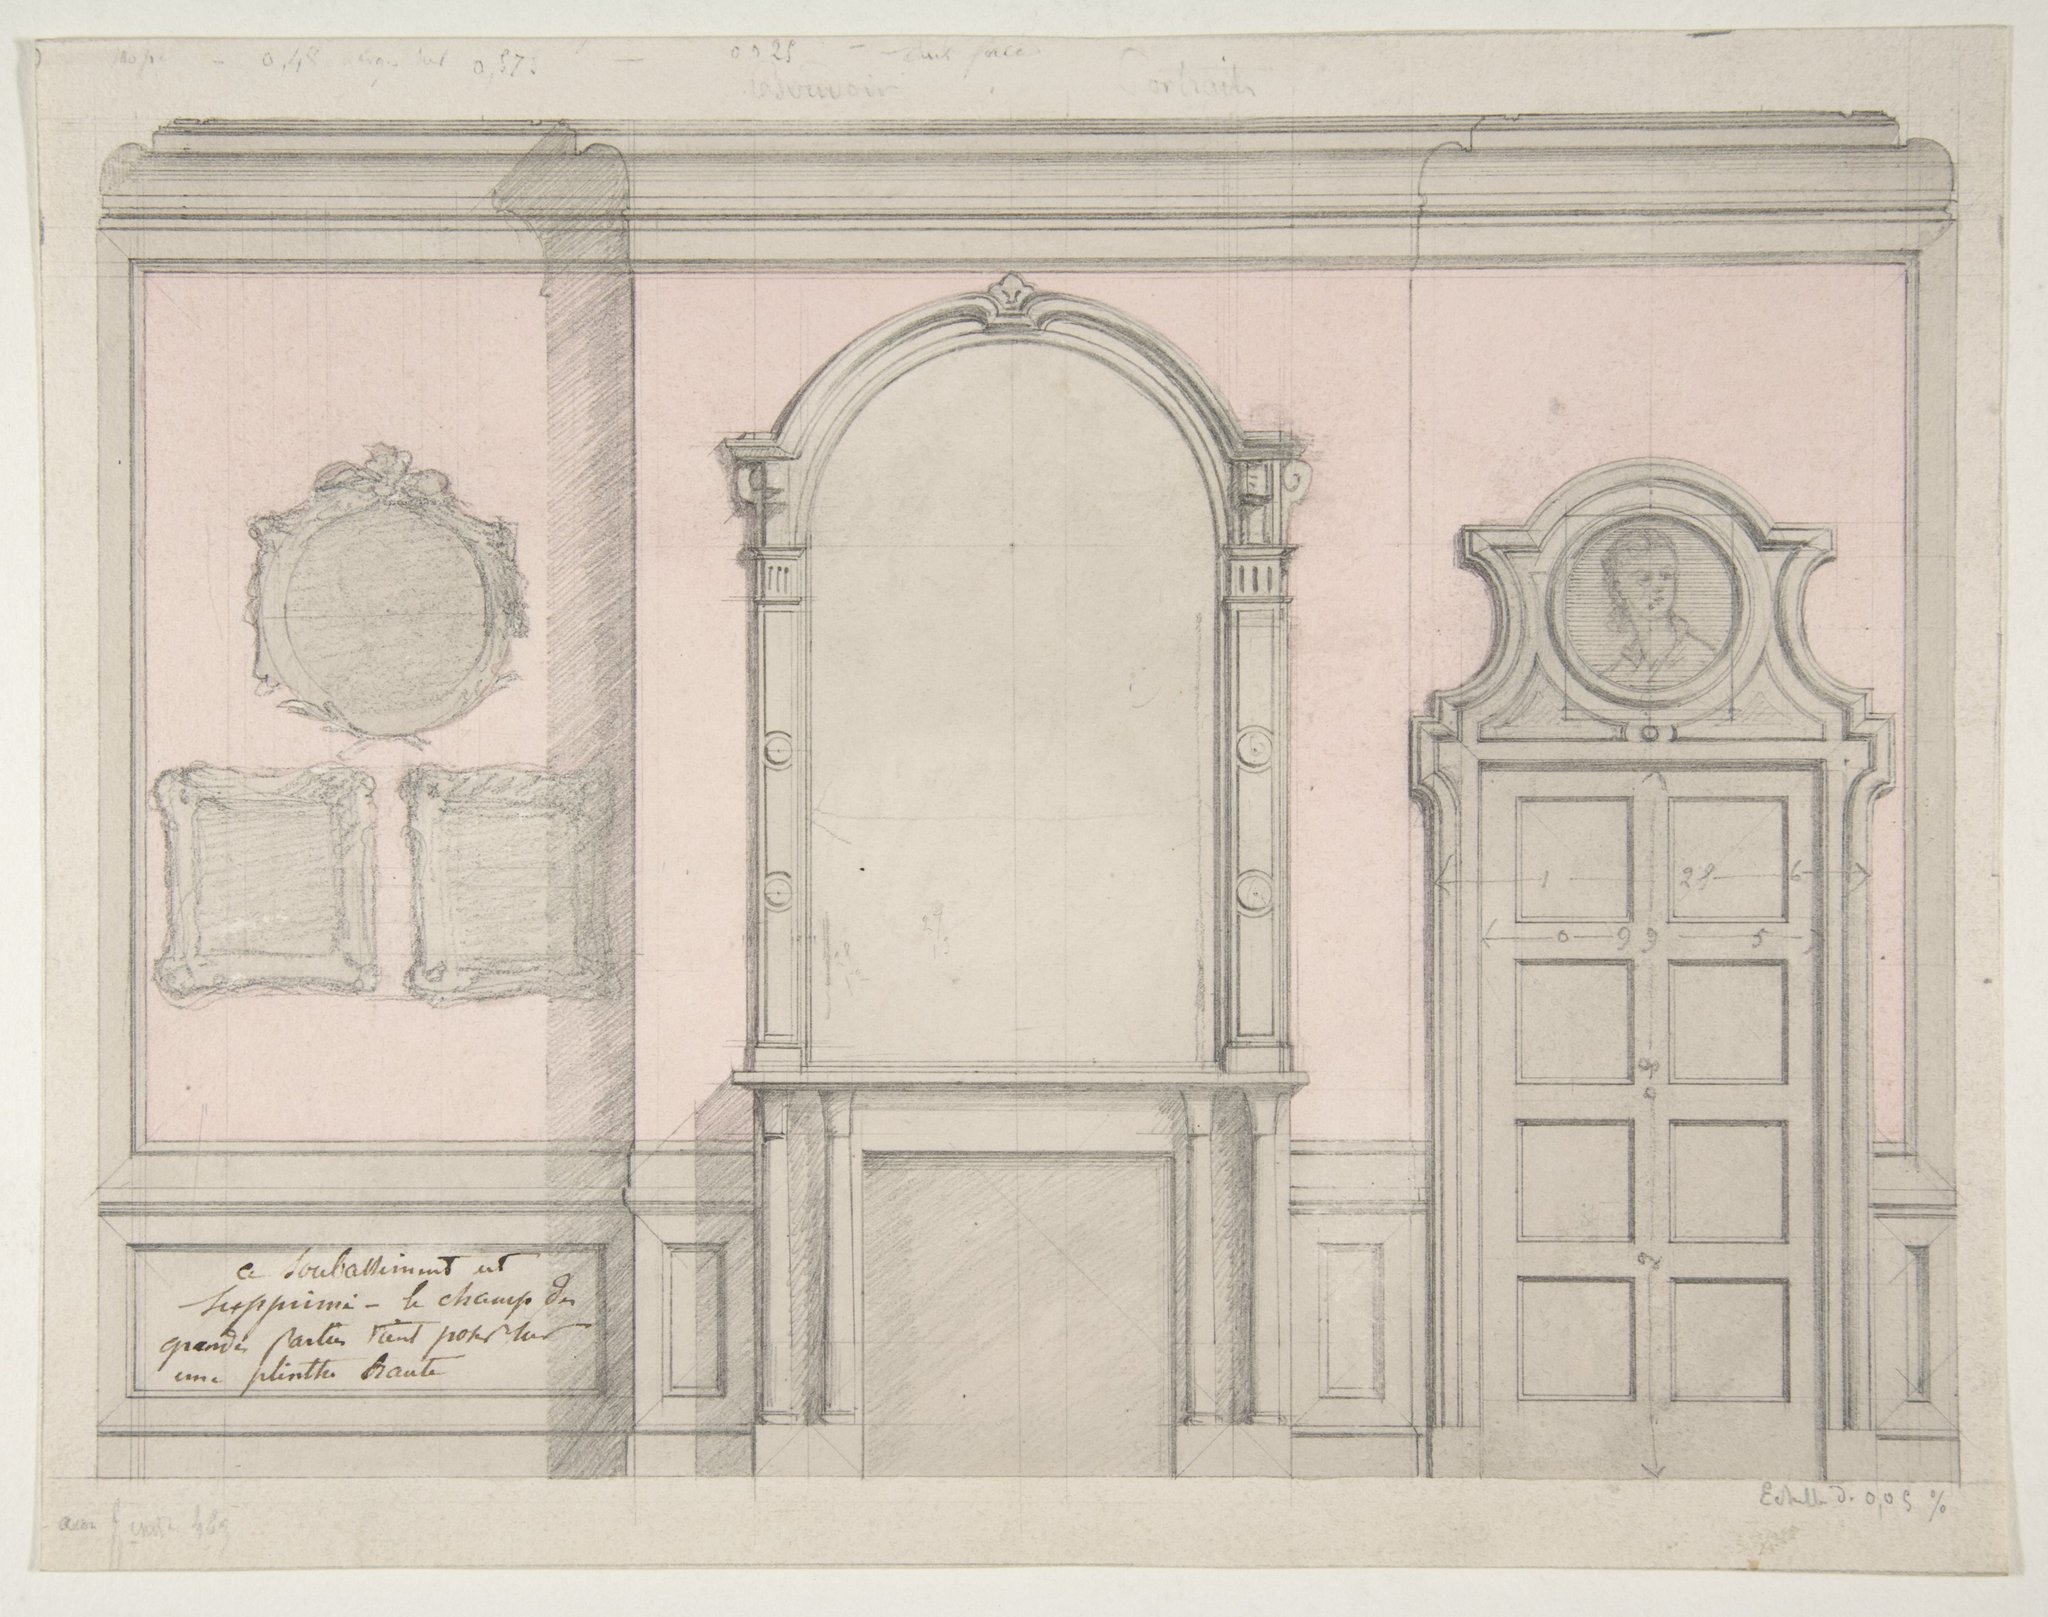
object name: drawing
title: Design for treatment of a chimney-piece and adjacent door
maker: jules-edmond-charles lachaise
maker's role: artist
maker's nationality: french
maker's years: 1897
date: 1830-1897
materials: graphite, watercolor, paper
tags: doors,fireplaces